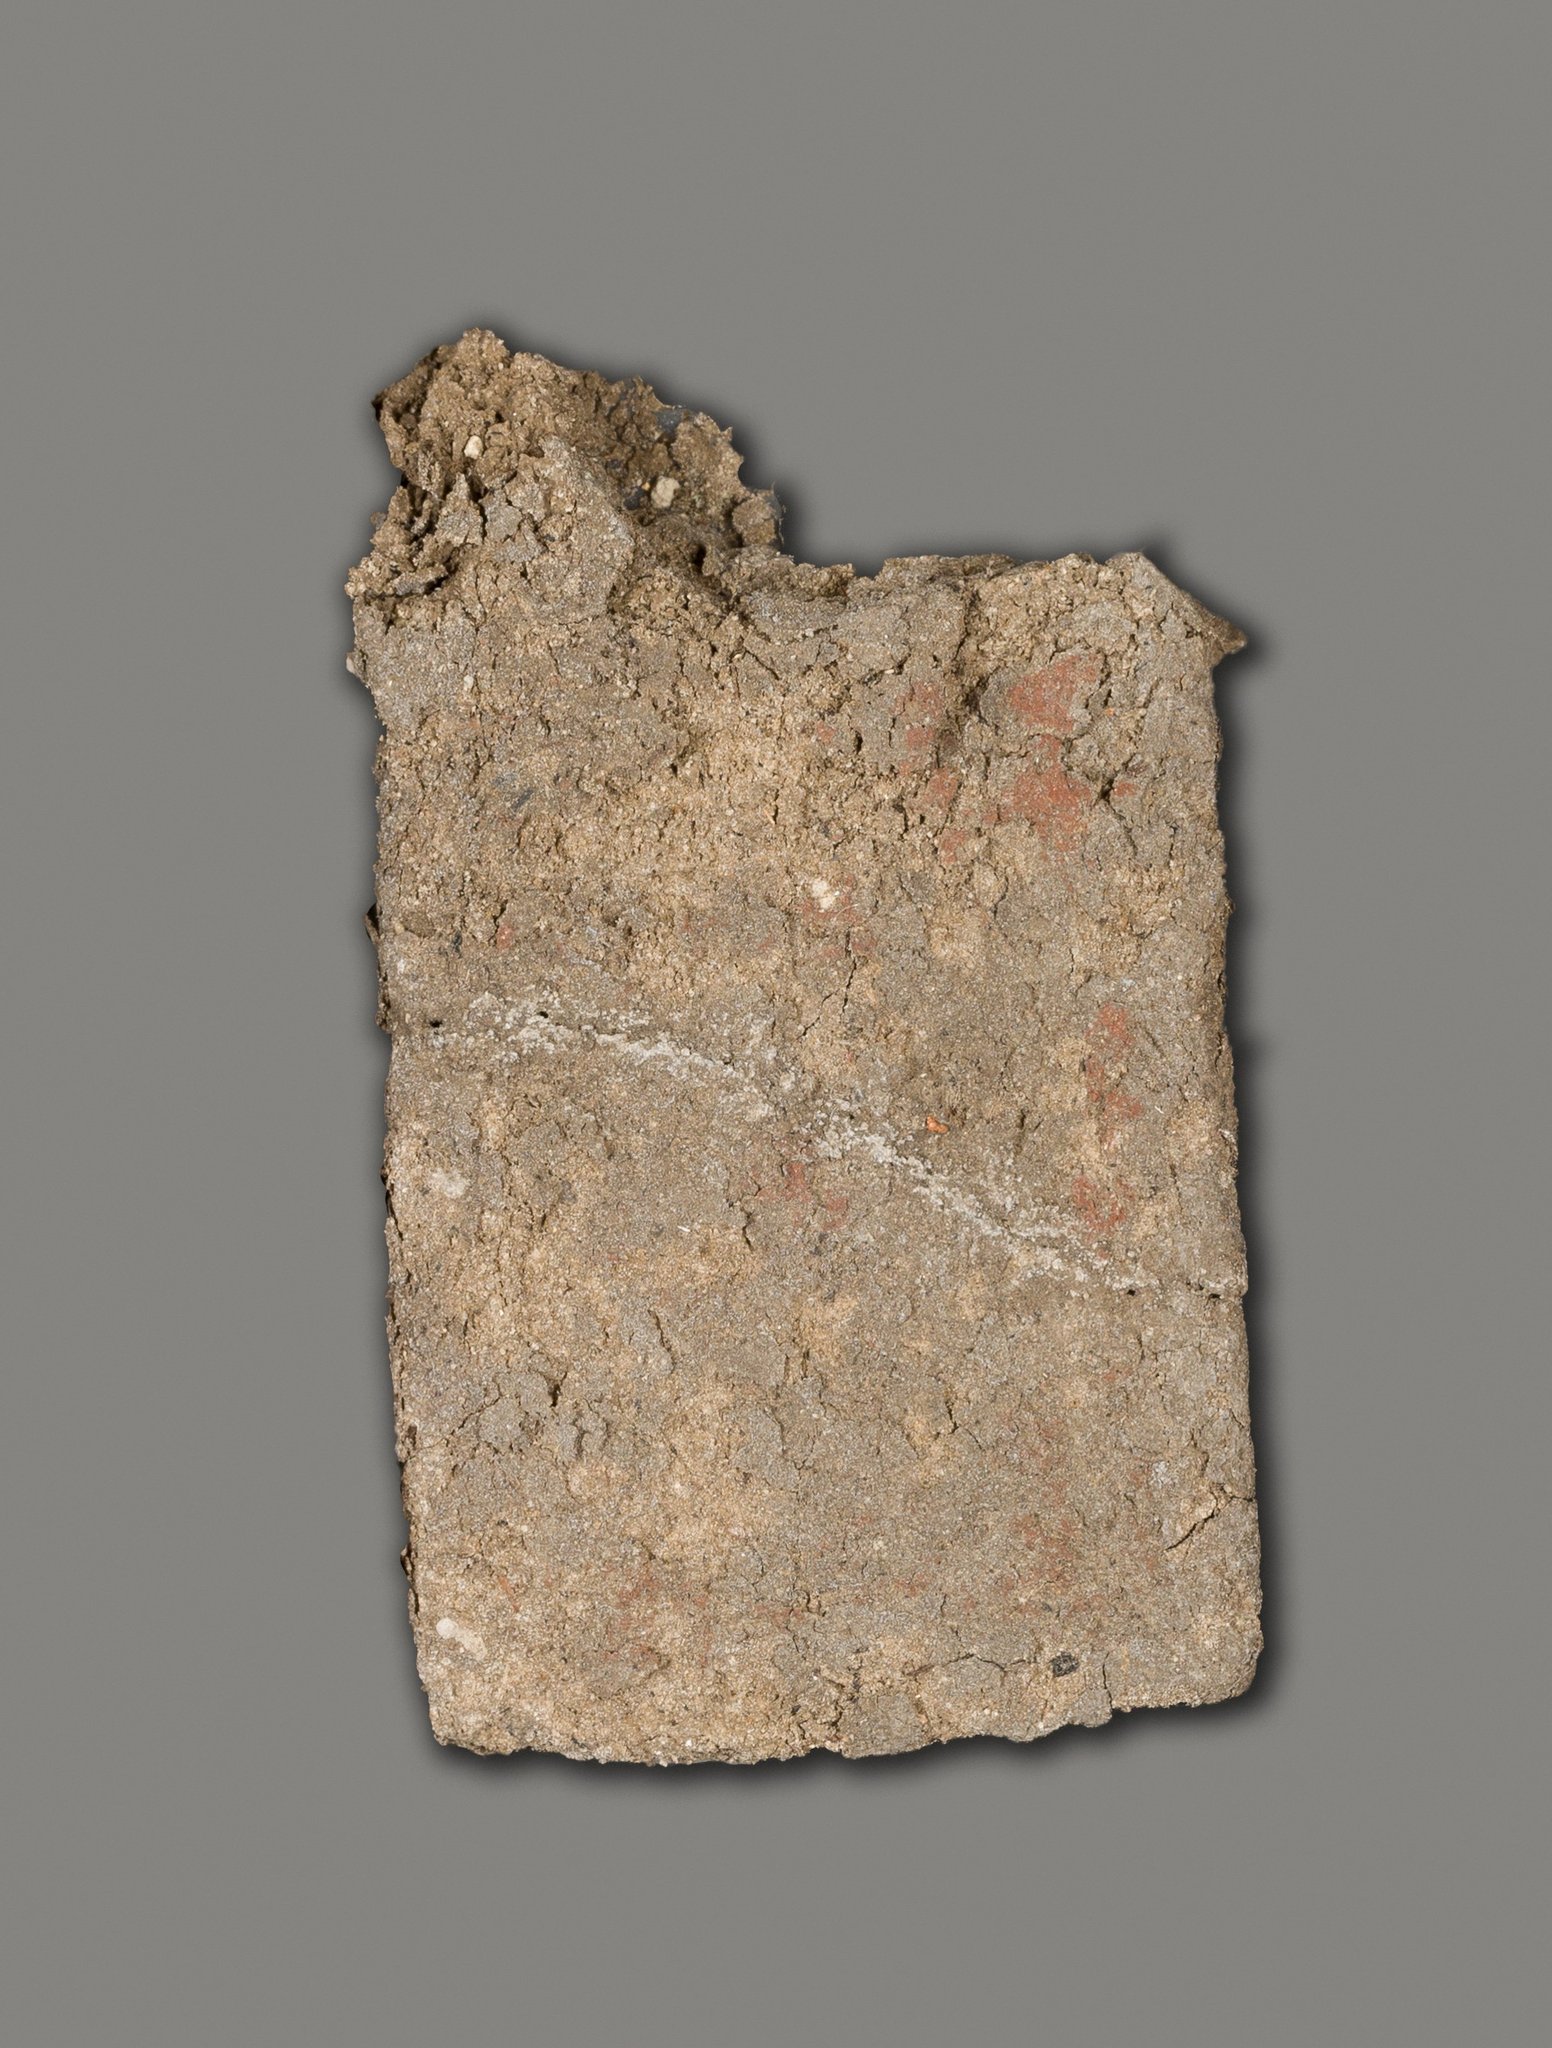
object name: figure, magical, execration, tablet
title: Magical Figure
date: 1802-1550 BCE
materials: clay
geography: egypt